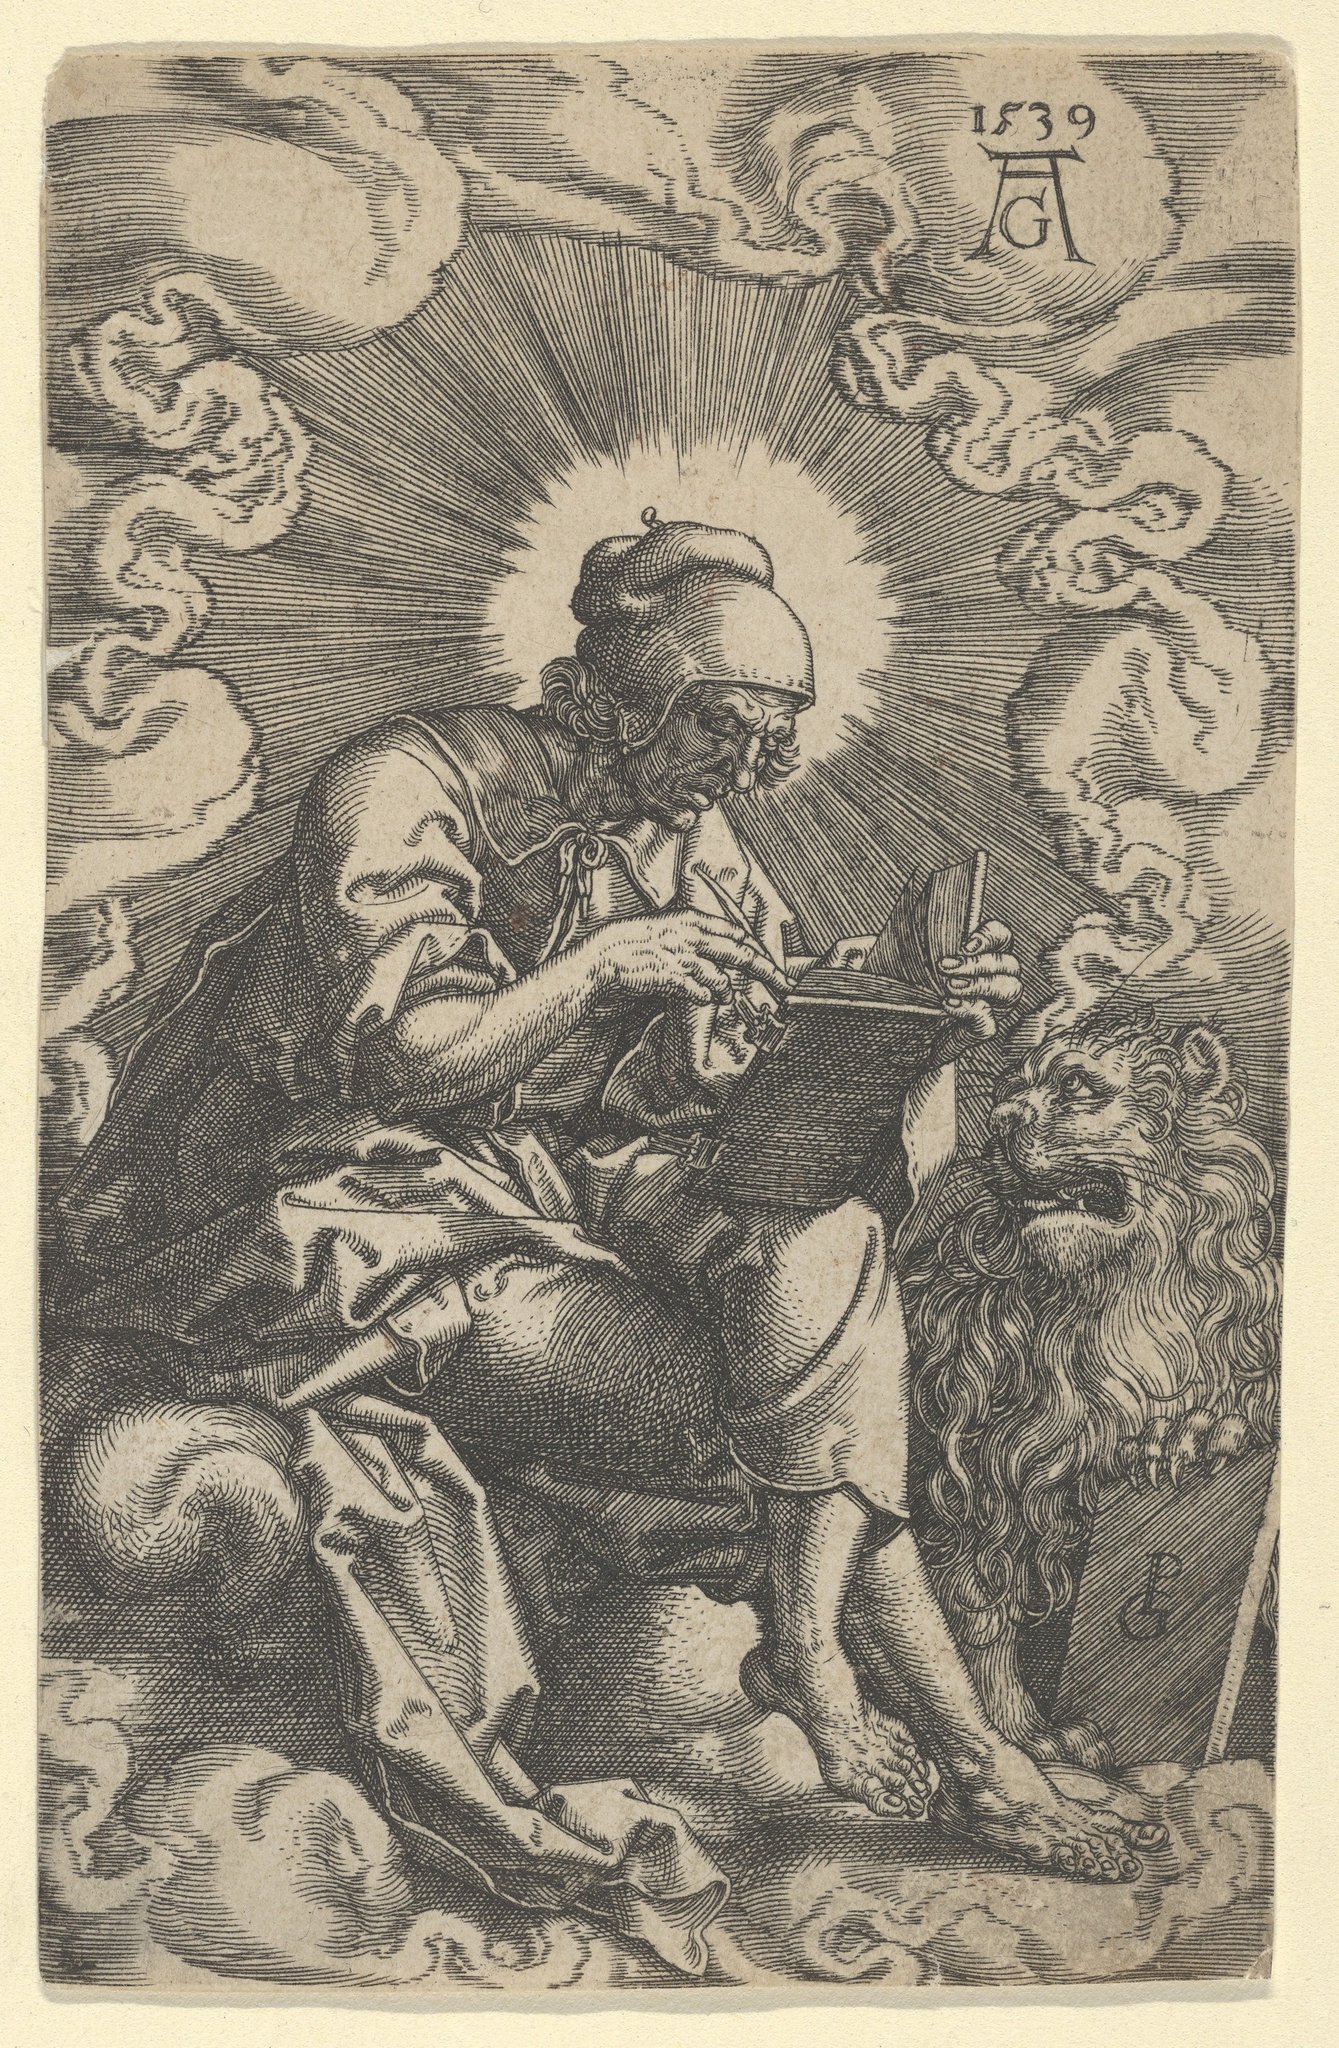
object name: print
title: Saint Mark, from "The Four Evangelists"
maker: heinrich aldegrever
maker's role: artist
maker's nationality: german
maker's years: 1502-1561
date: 1539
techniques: engraving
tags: lions,saint mark,writing